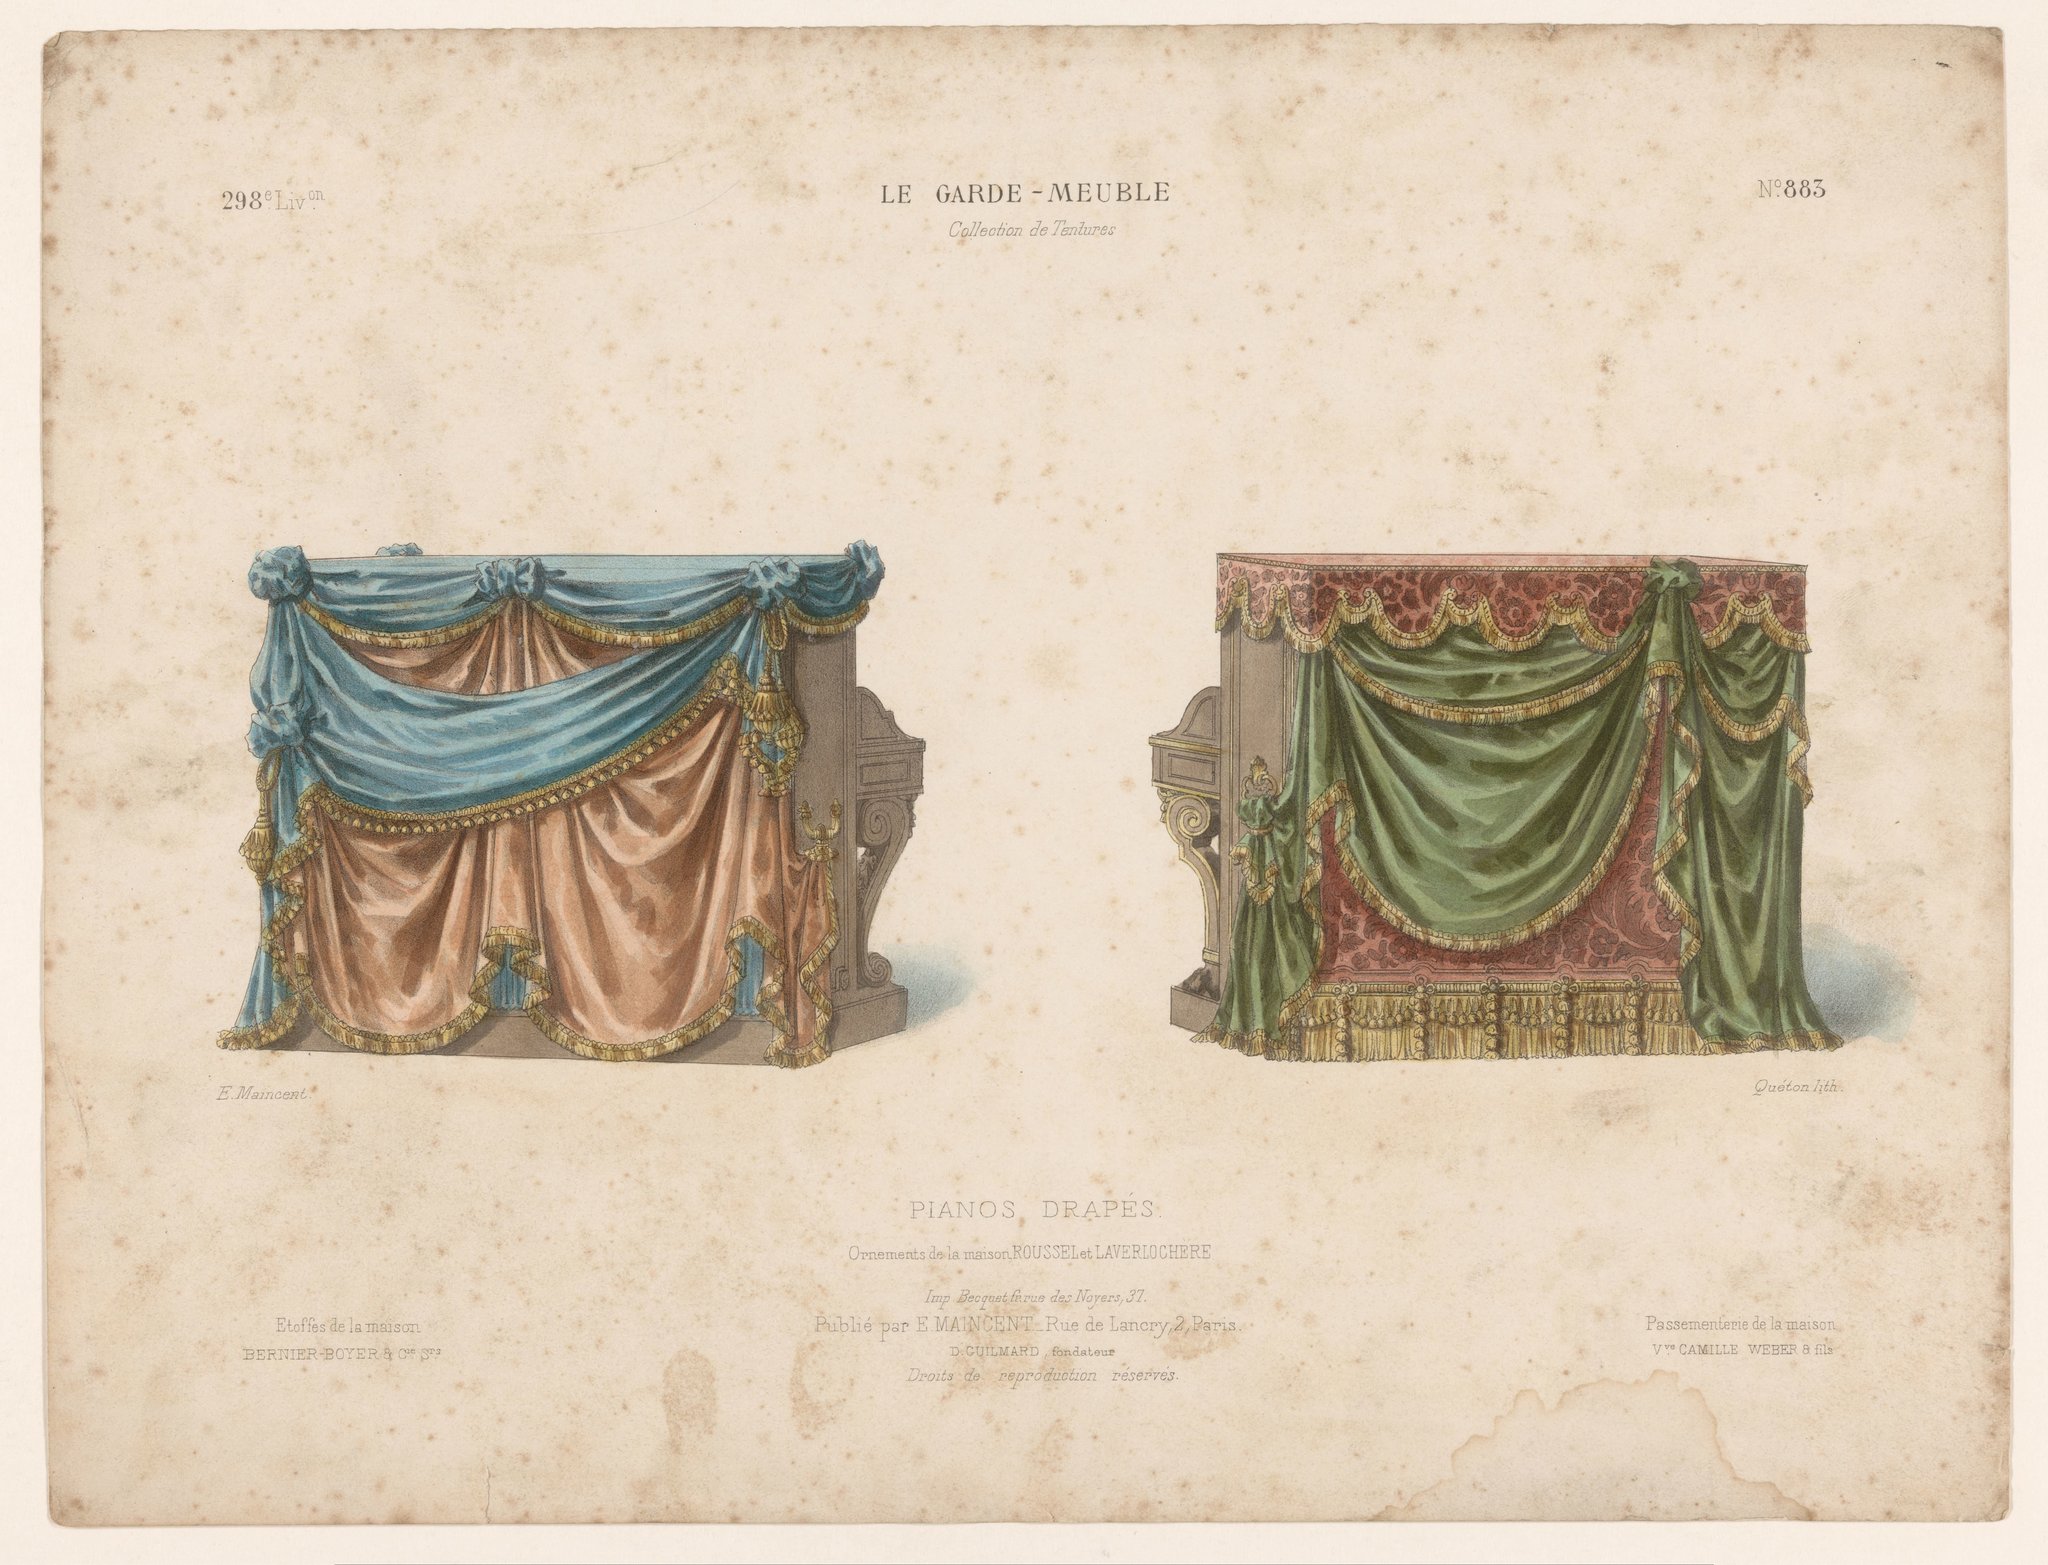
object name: print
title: Pianos drapés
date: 1885-1895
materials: paper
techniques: hand coloring, lithograph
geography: paris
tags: decorations (interior of the house), hangings and drapery, pianoforte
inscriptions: : ‘Droits de reproduction réservés.’